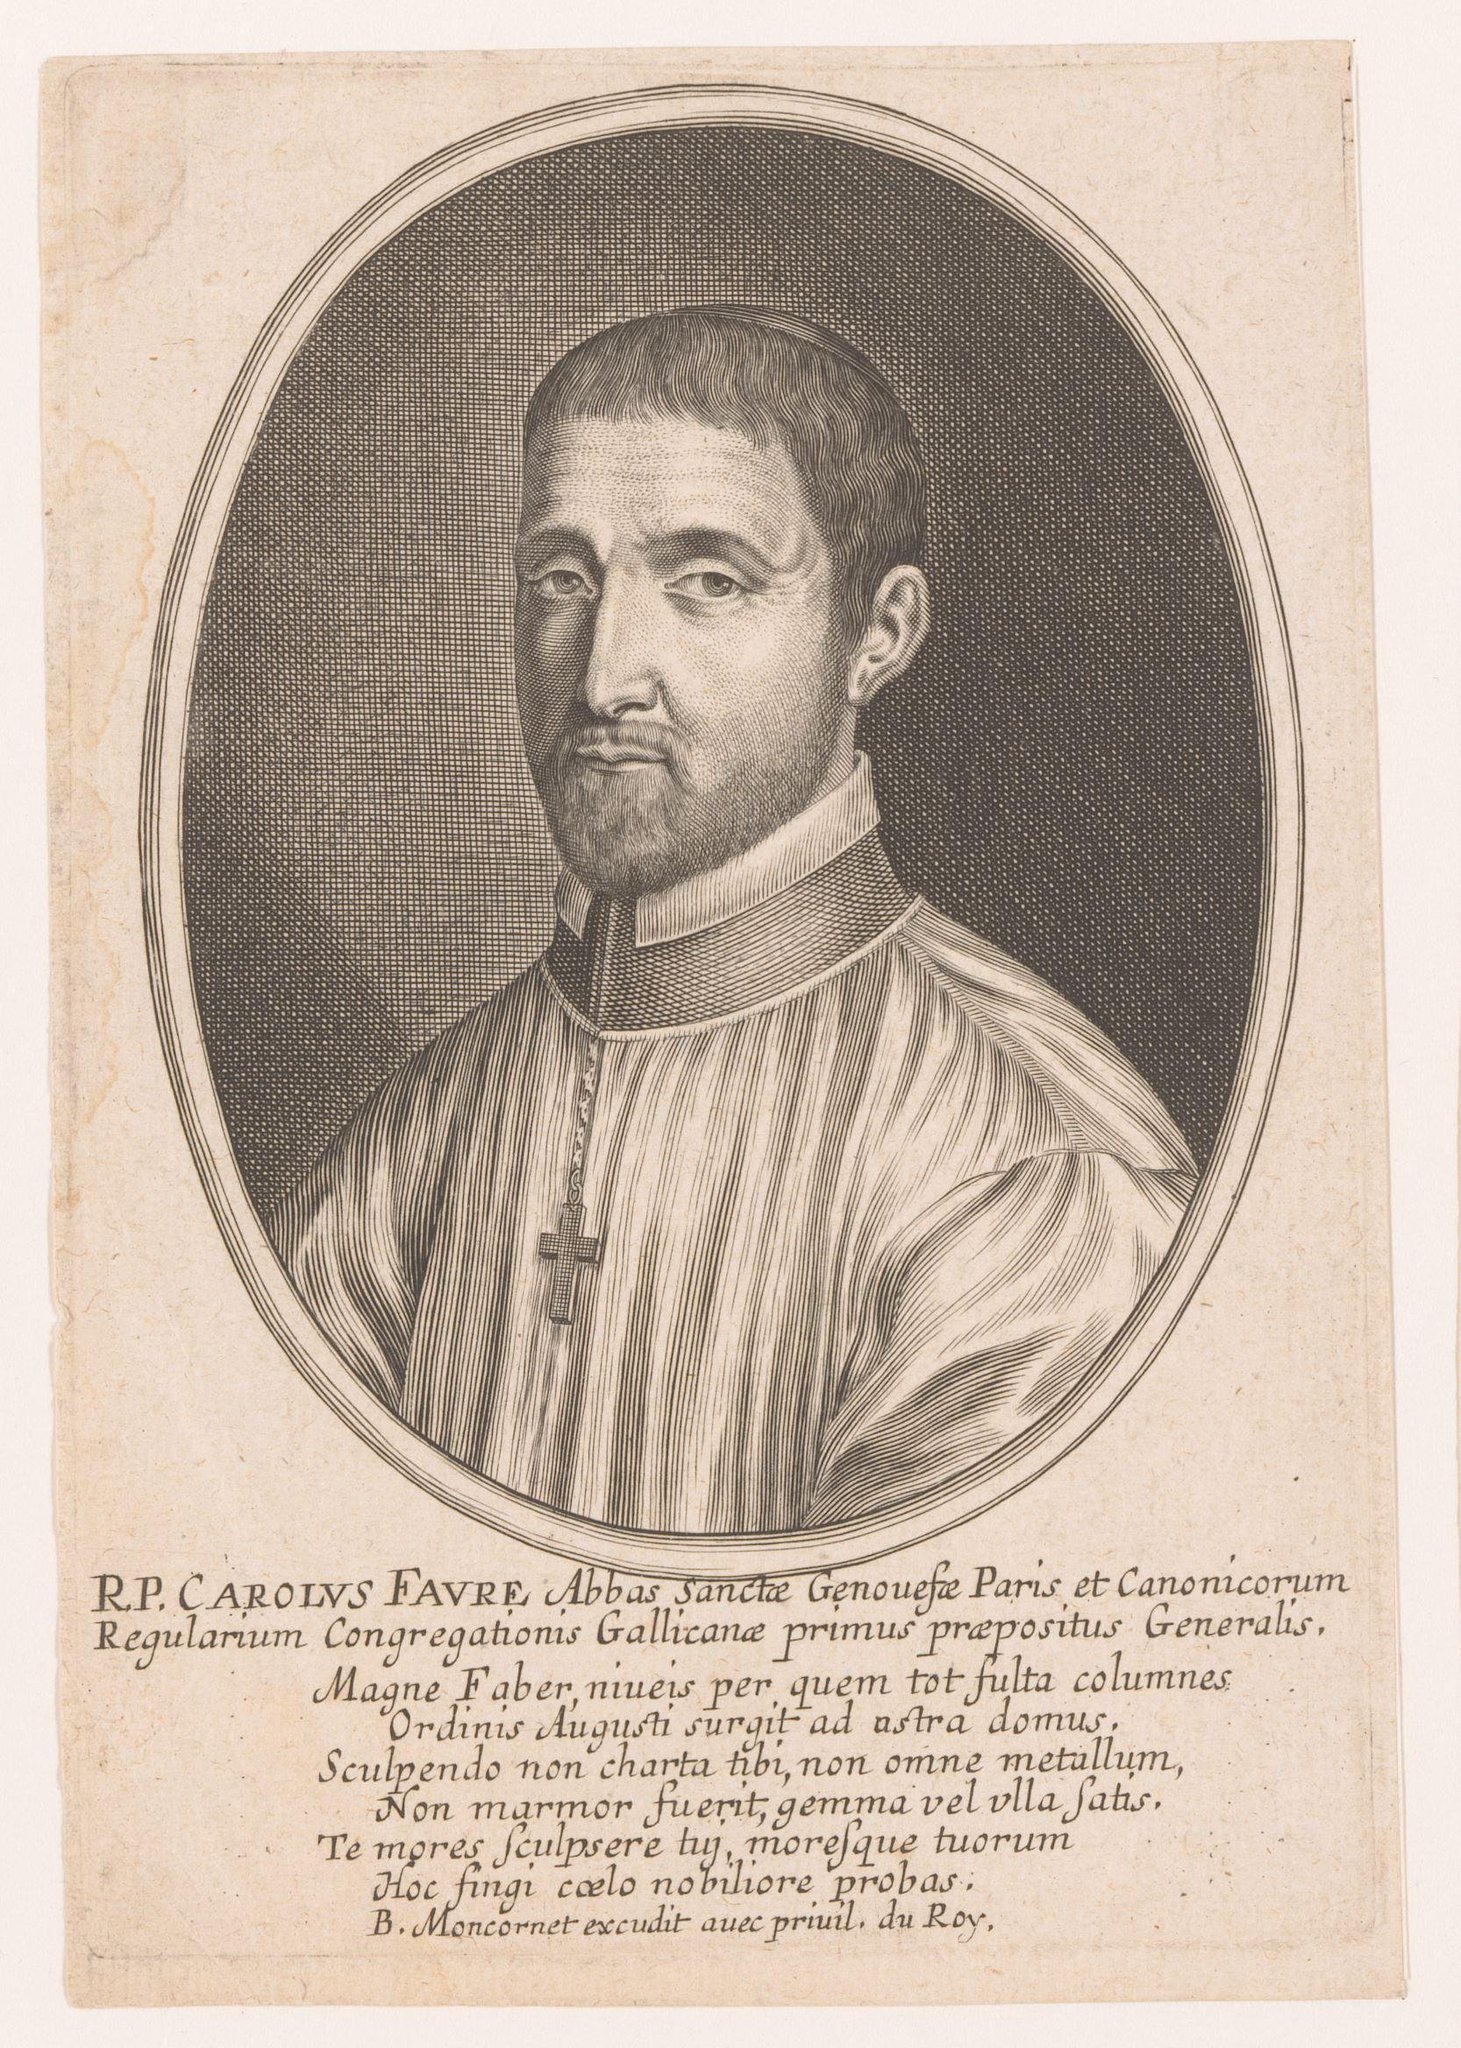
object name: print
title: Portret van Charles Faure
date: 1610-1668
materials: paper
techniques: engraving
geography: france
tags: clergyman, charles faure, priest (roman catholic), historical persons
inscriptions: collector's mark: Lugt 2228